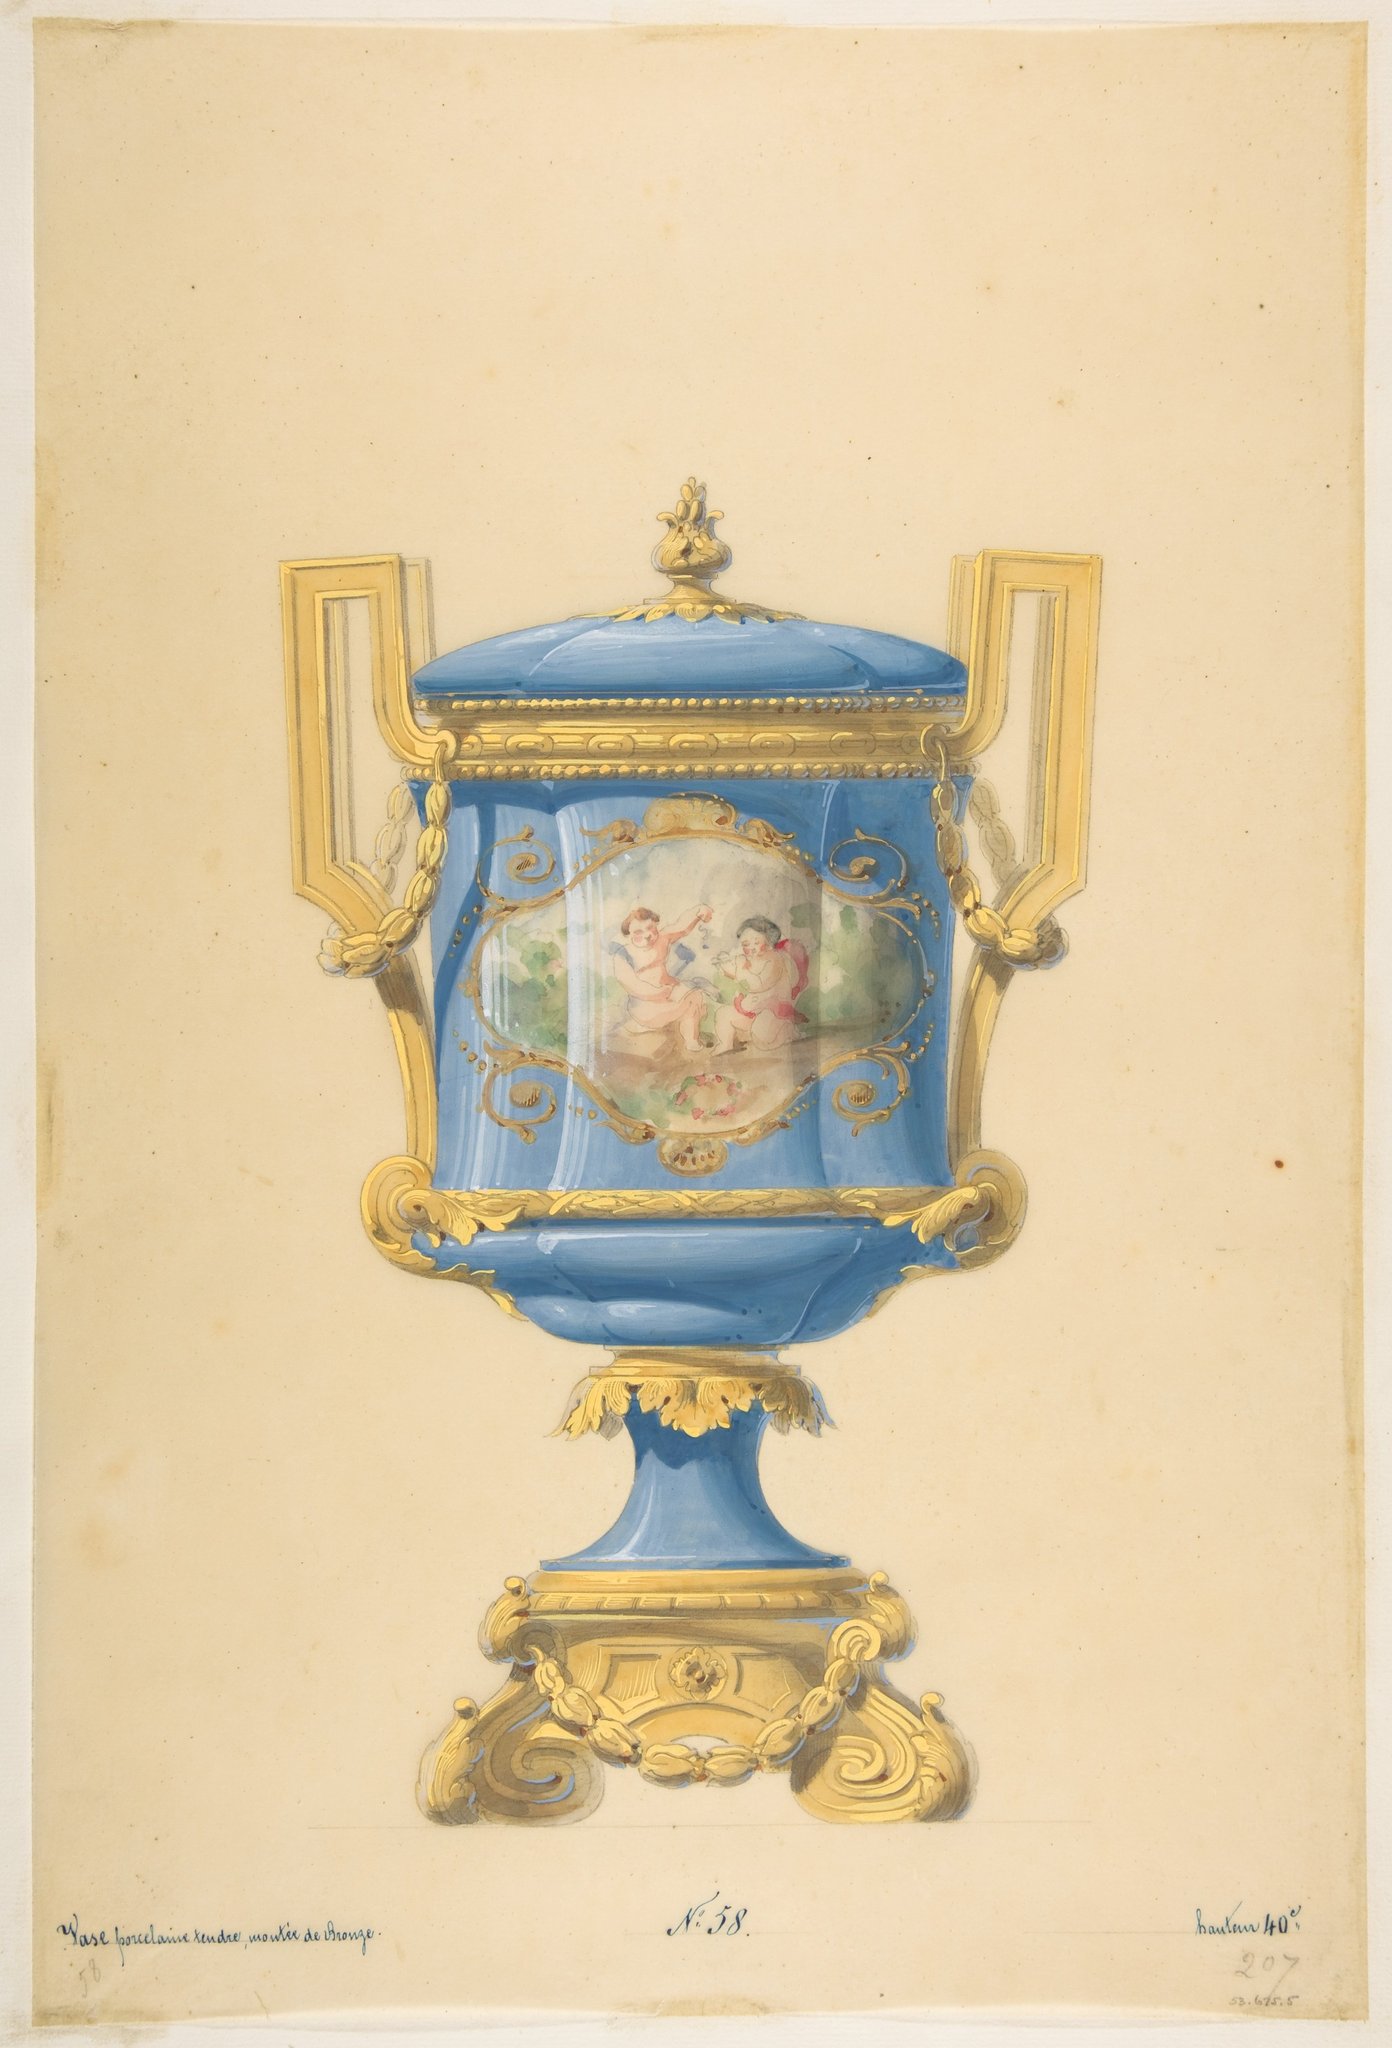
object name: drawing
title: Design for an Urn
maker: anonymous, french, 19th century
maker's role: artist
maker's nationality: french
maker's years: 1800-1900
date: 1801-1900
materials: gilt, gold, gouache, graphite, watercolor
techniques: brush, wash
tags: human figures,urns